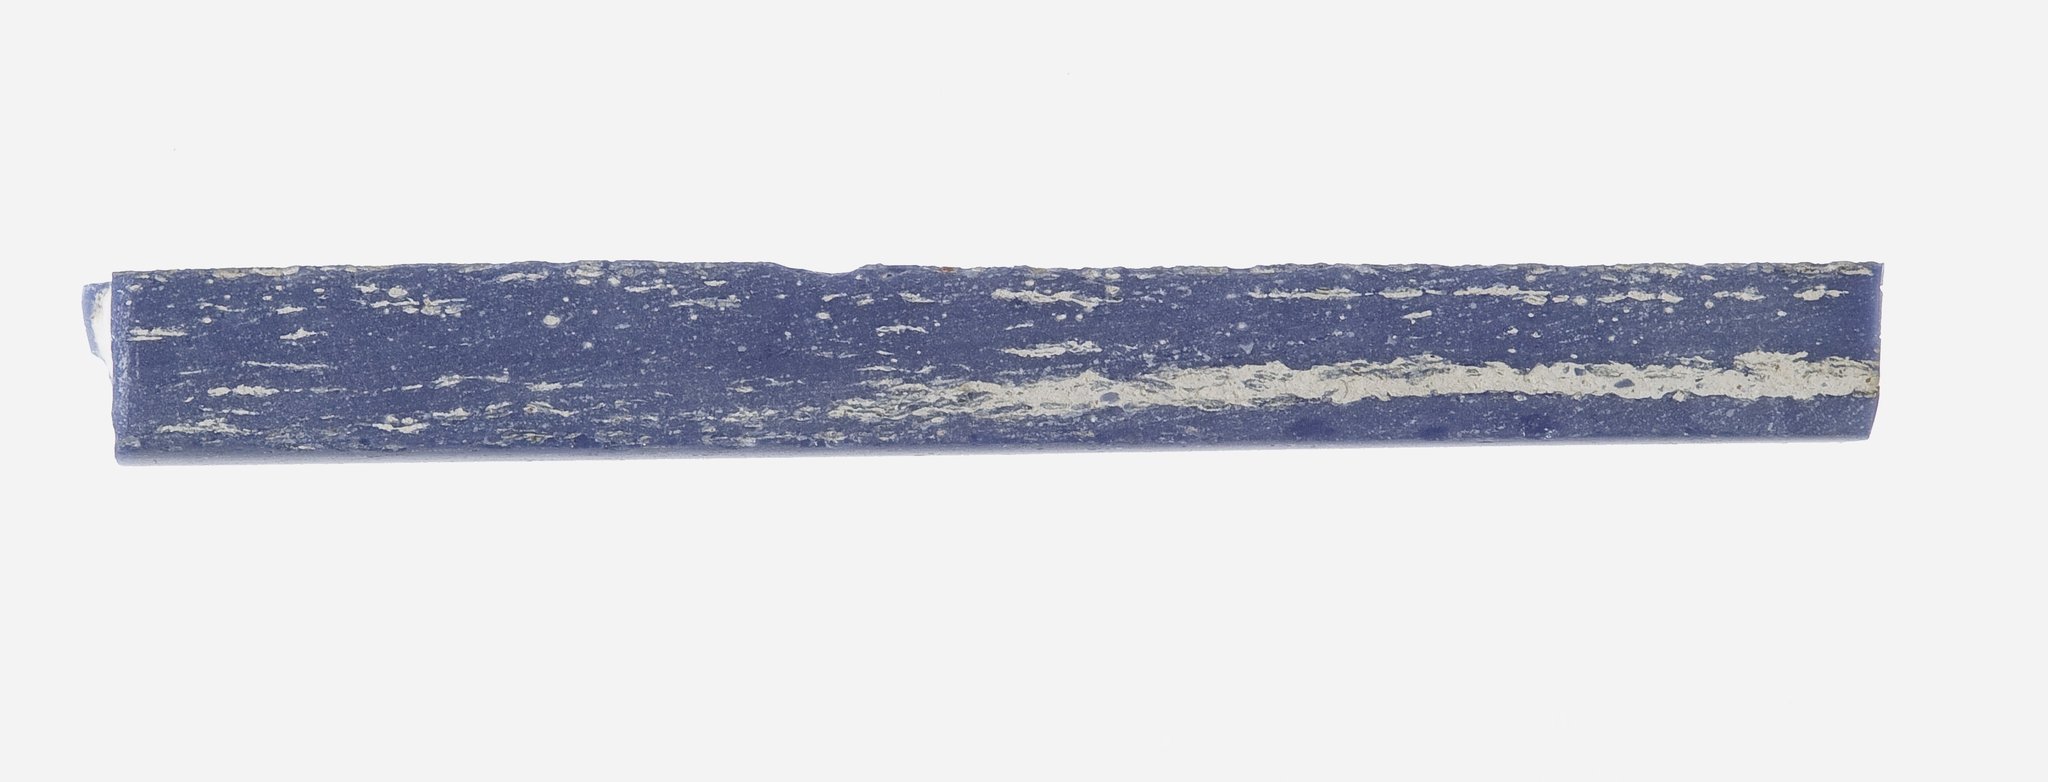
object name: glass rod, blue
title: Rod of Opaque Blue Glass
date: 1390-1352 BCE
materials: glass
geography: egypt